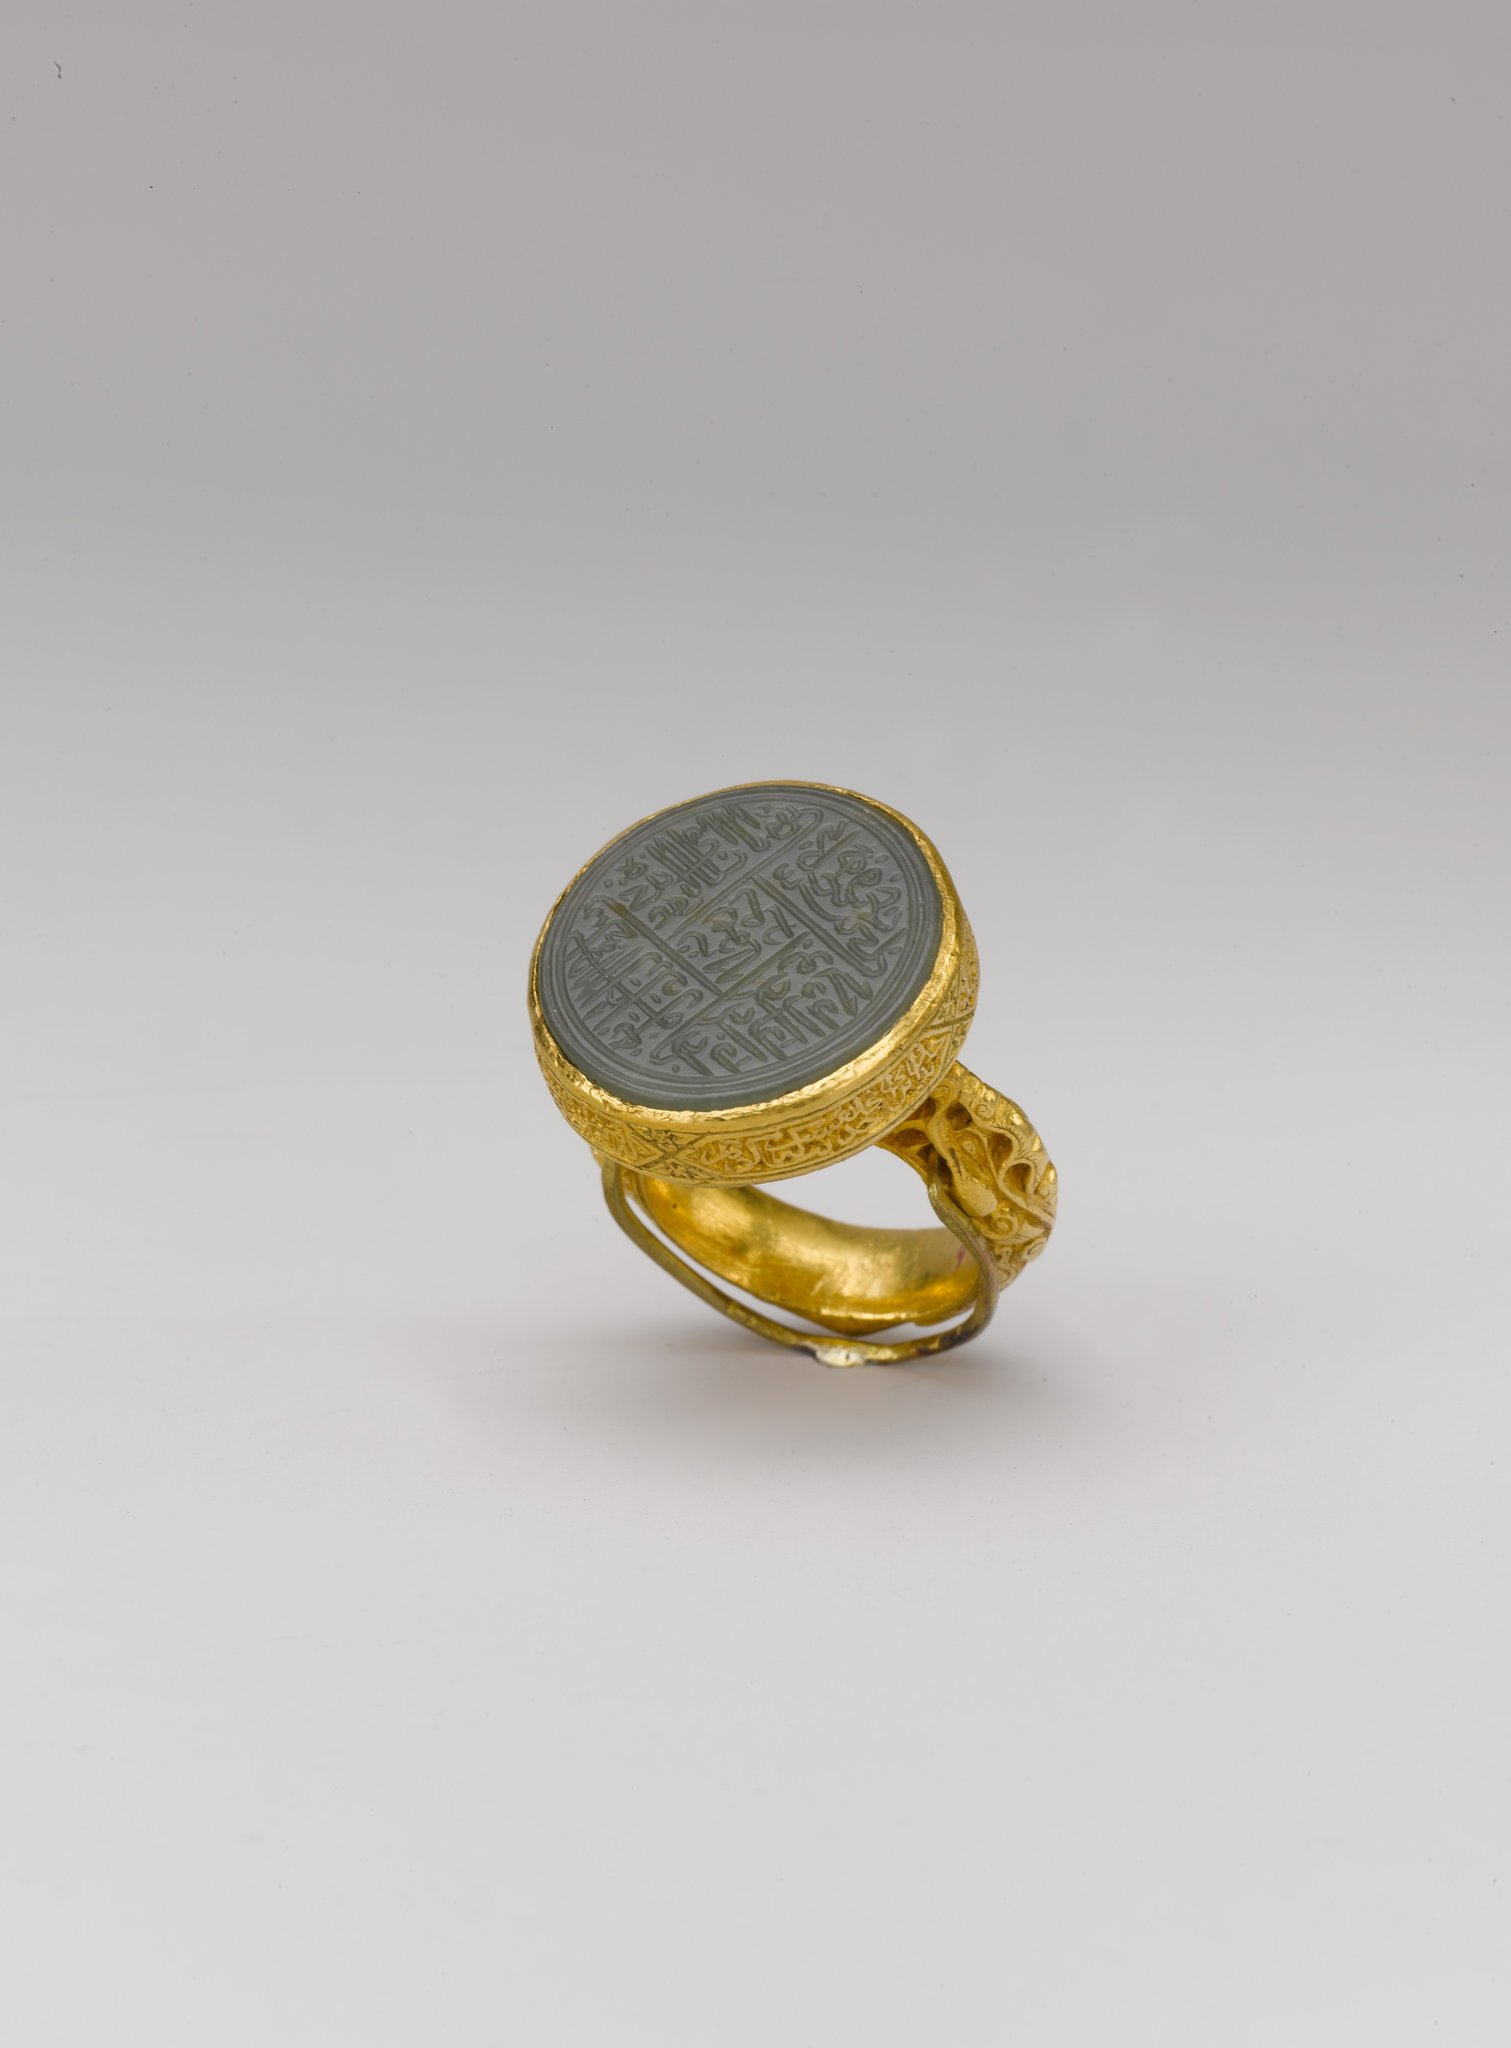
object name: ring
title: Seal Ring with Inscription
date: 1467-1533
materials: gold, jade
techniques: carving, casting, chasing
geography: iran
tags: arabic